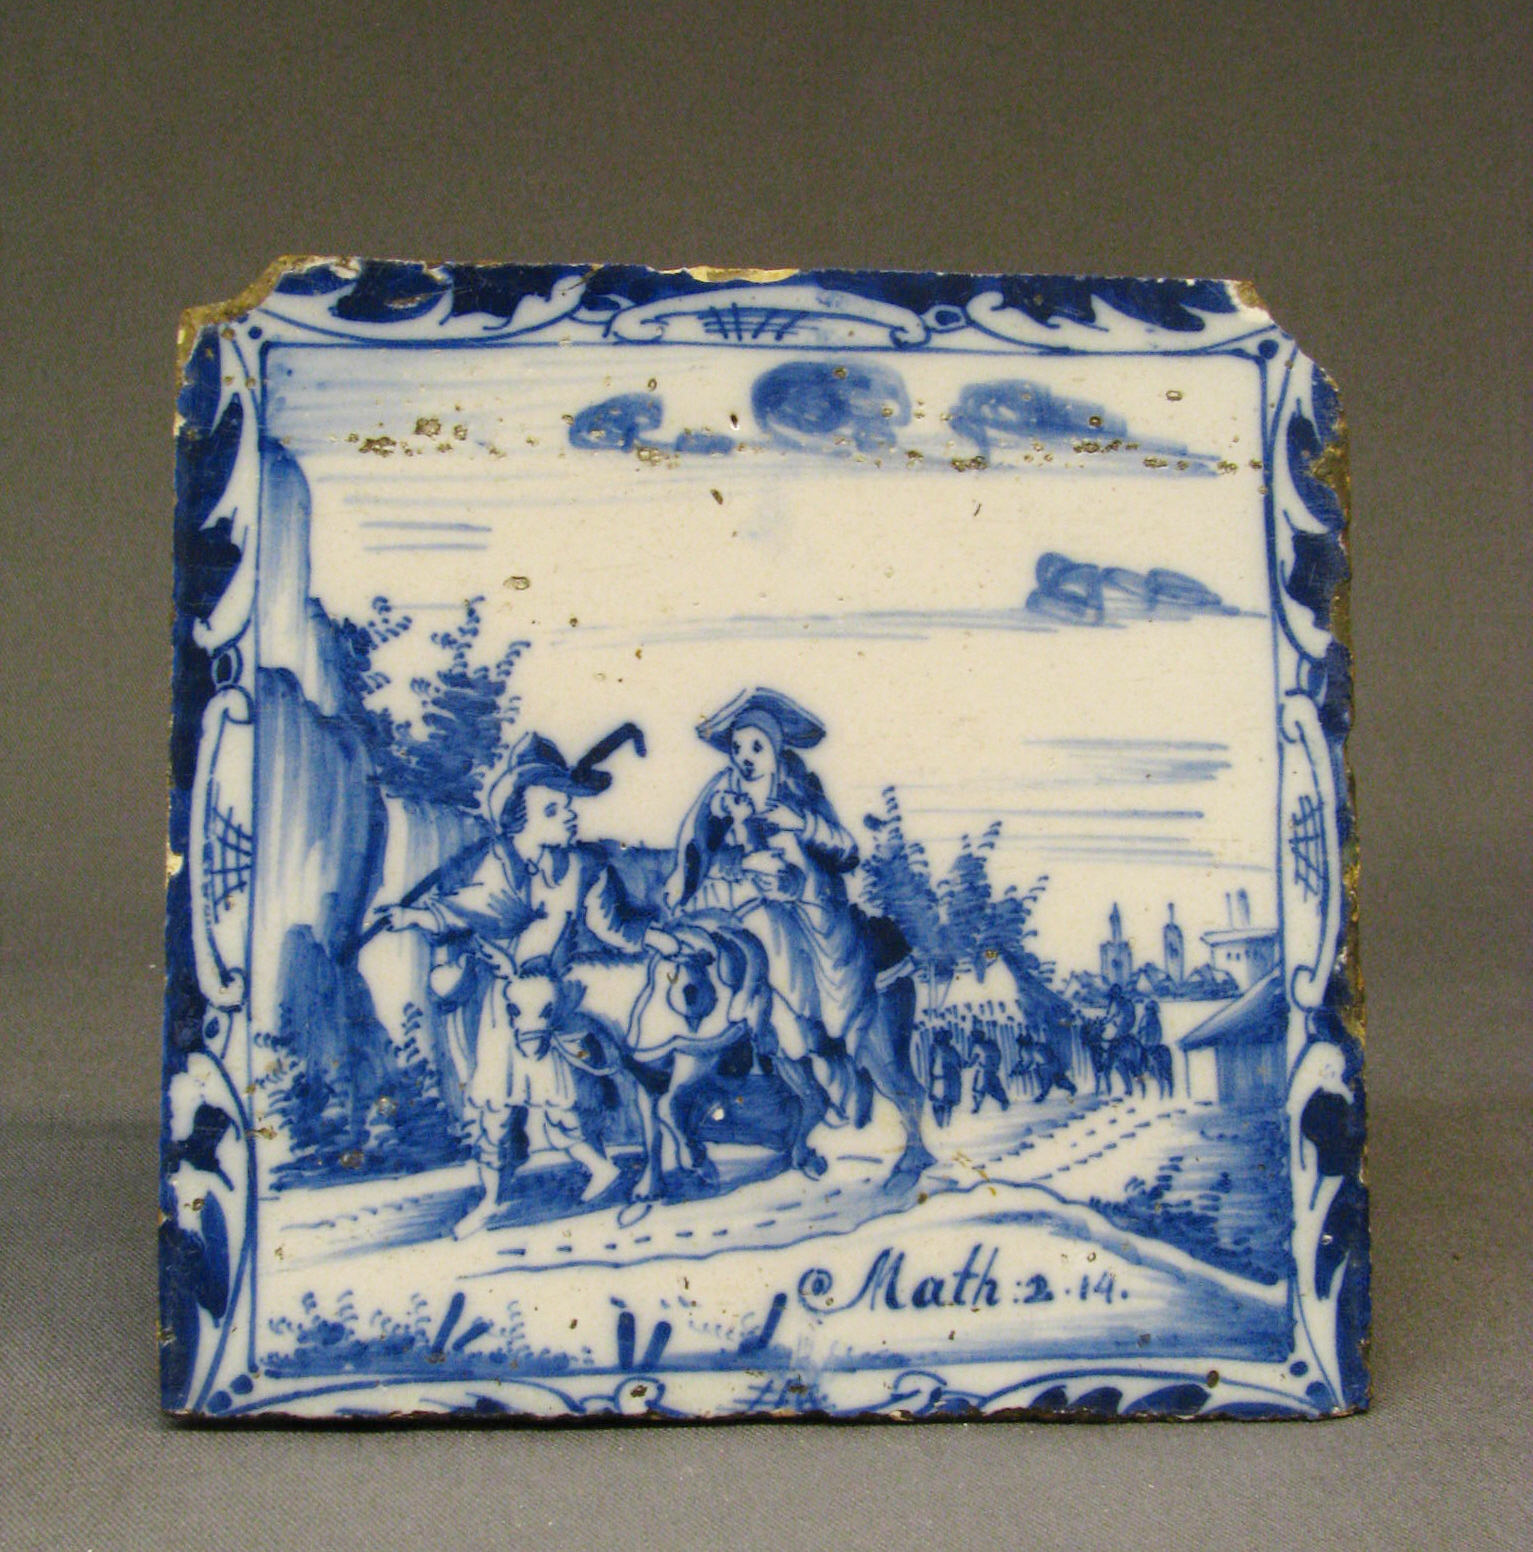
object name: tile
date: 1701-1800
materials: earthenware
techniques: glazing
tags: infants,men,women,donkeys